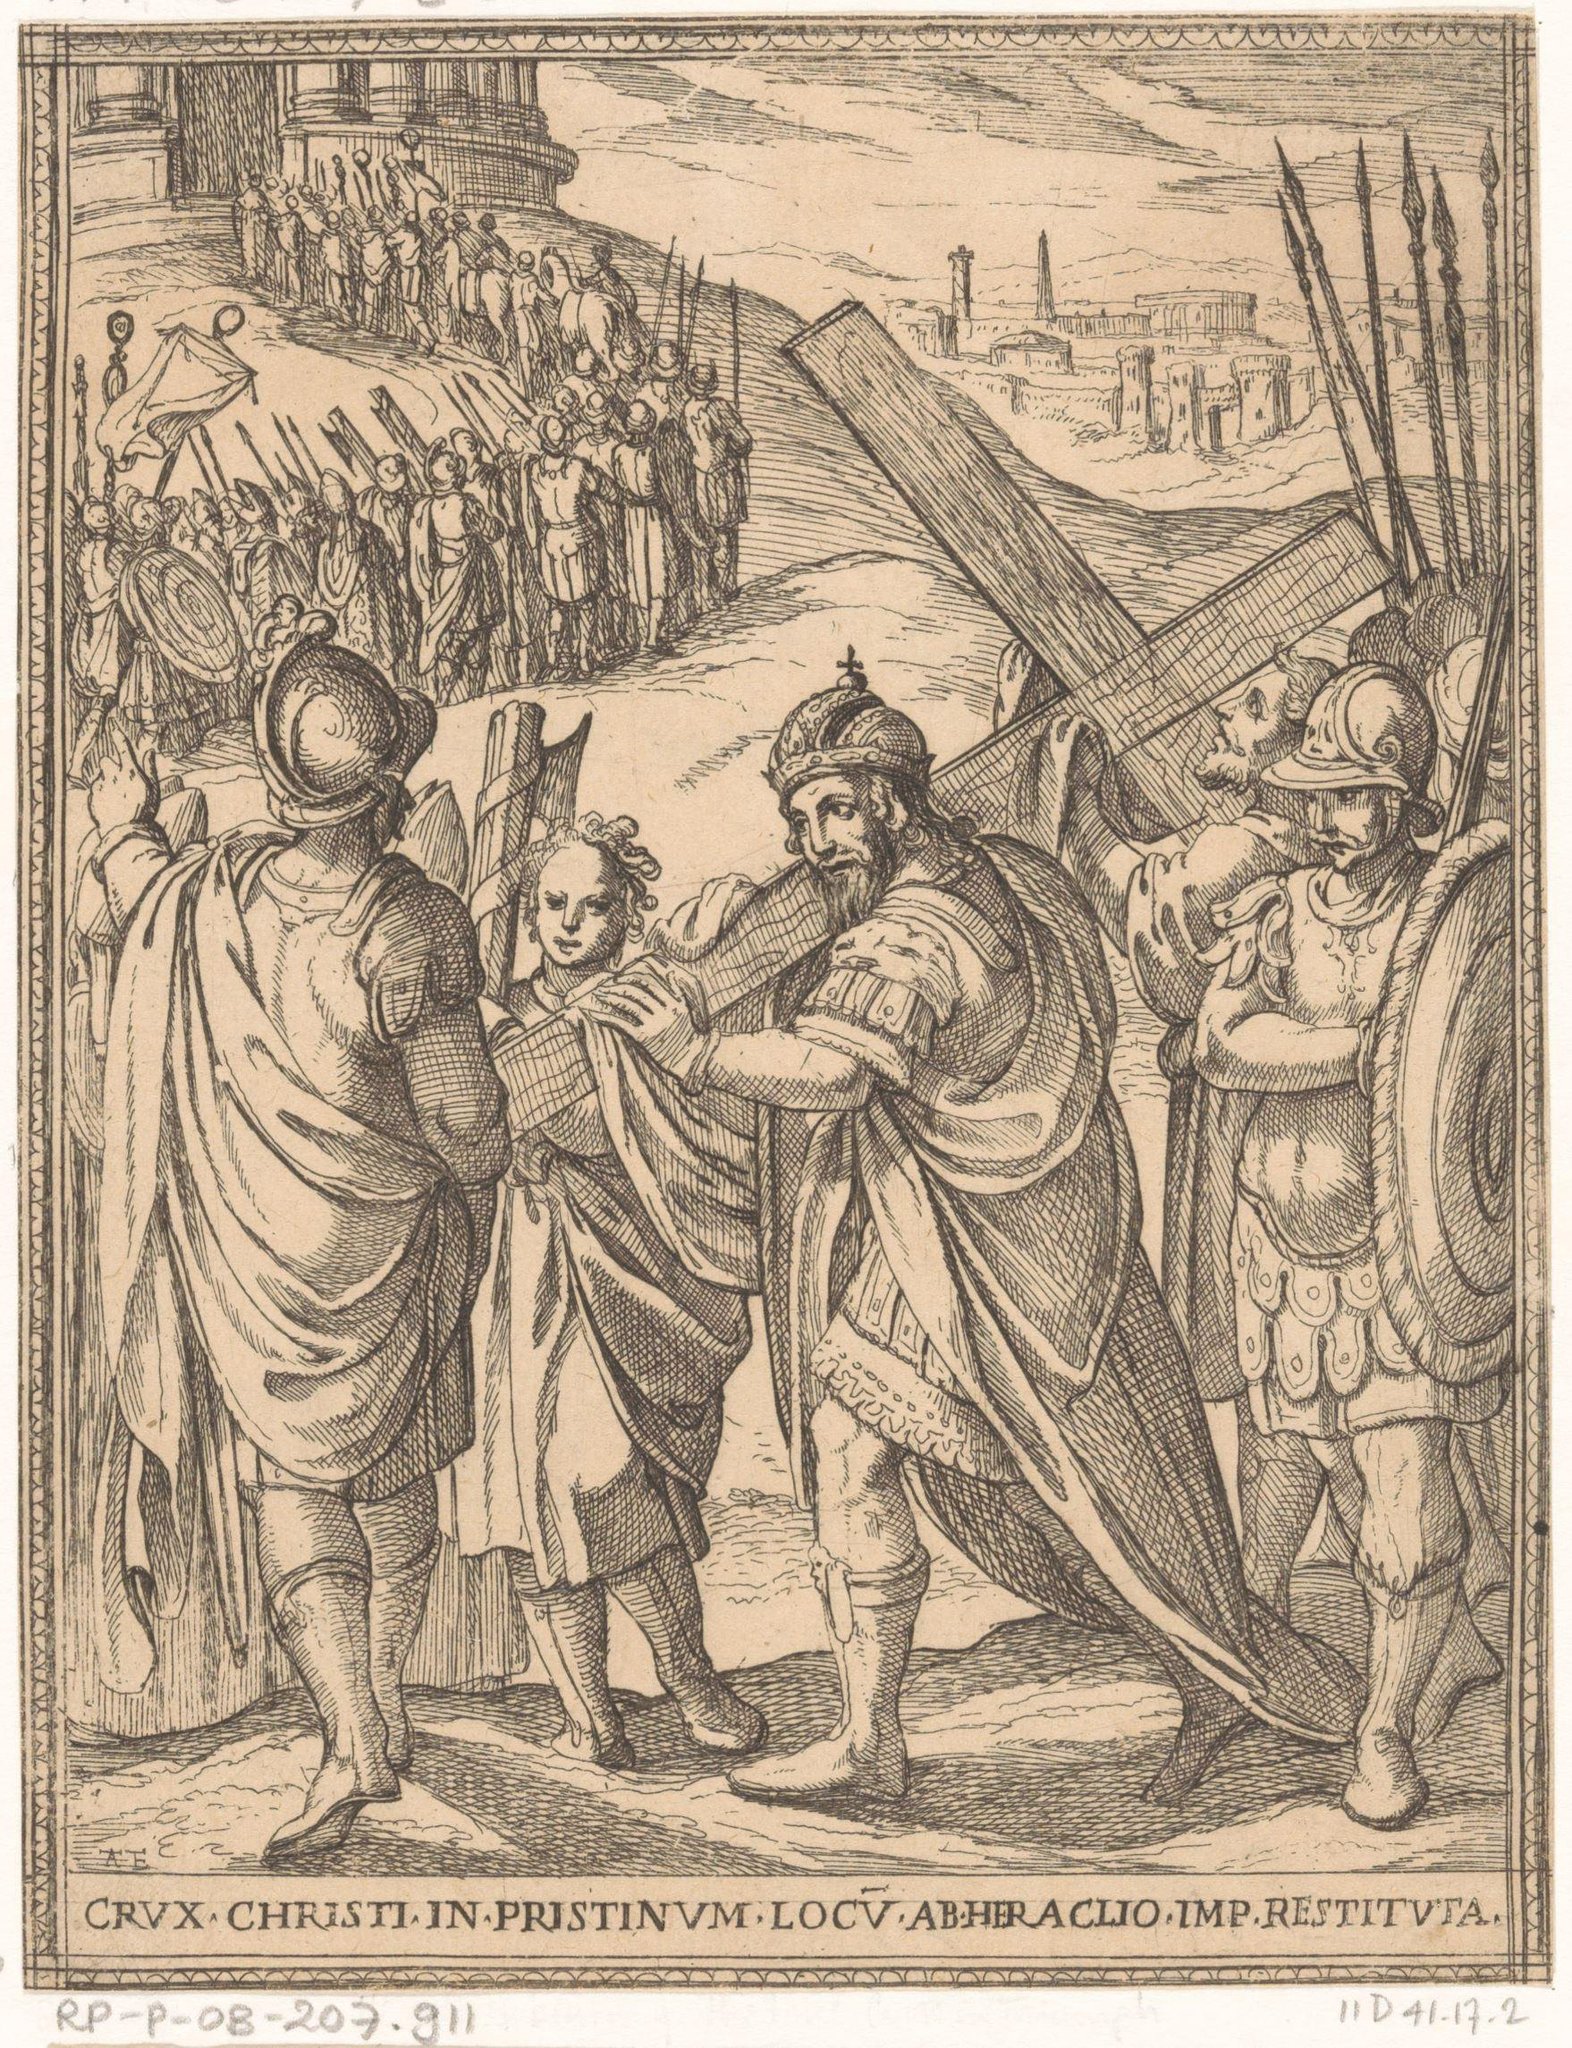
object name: print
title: Isagogia historia de Constantino max: imperatore instatuta militie angelicae aureatae Constantinianae sub titulo magni martyris S Georgii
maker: antonio tempesta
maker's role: draughtsman, painter, print maker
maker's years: 1555-1630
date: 1565-1630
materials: paper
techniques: etching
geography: italy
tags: emperor heraclius defeats chosroes ii of persia, and recovers a part of the true cross, the soldier; the soldier's life, procession ~ christian religion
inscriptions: collector's mark: Lugt 240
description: Keizer Heraclius draagt het kruis van Christus in triomf op zijn schouders in een processie door een landschap richting een tempel.